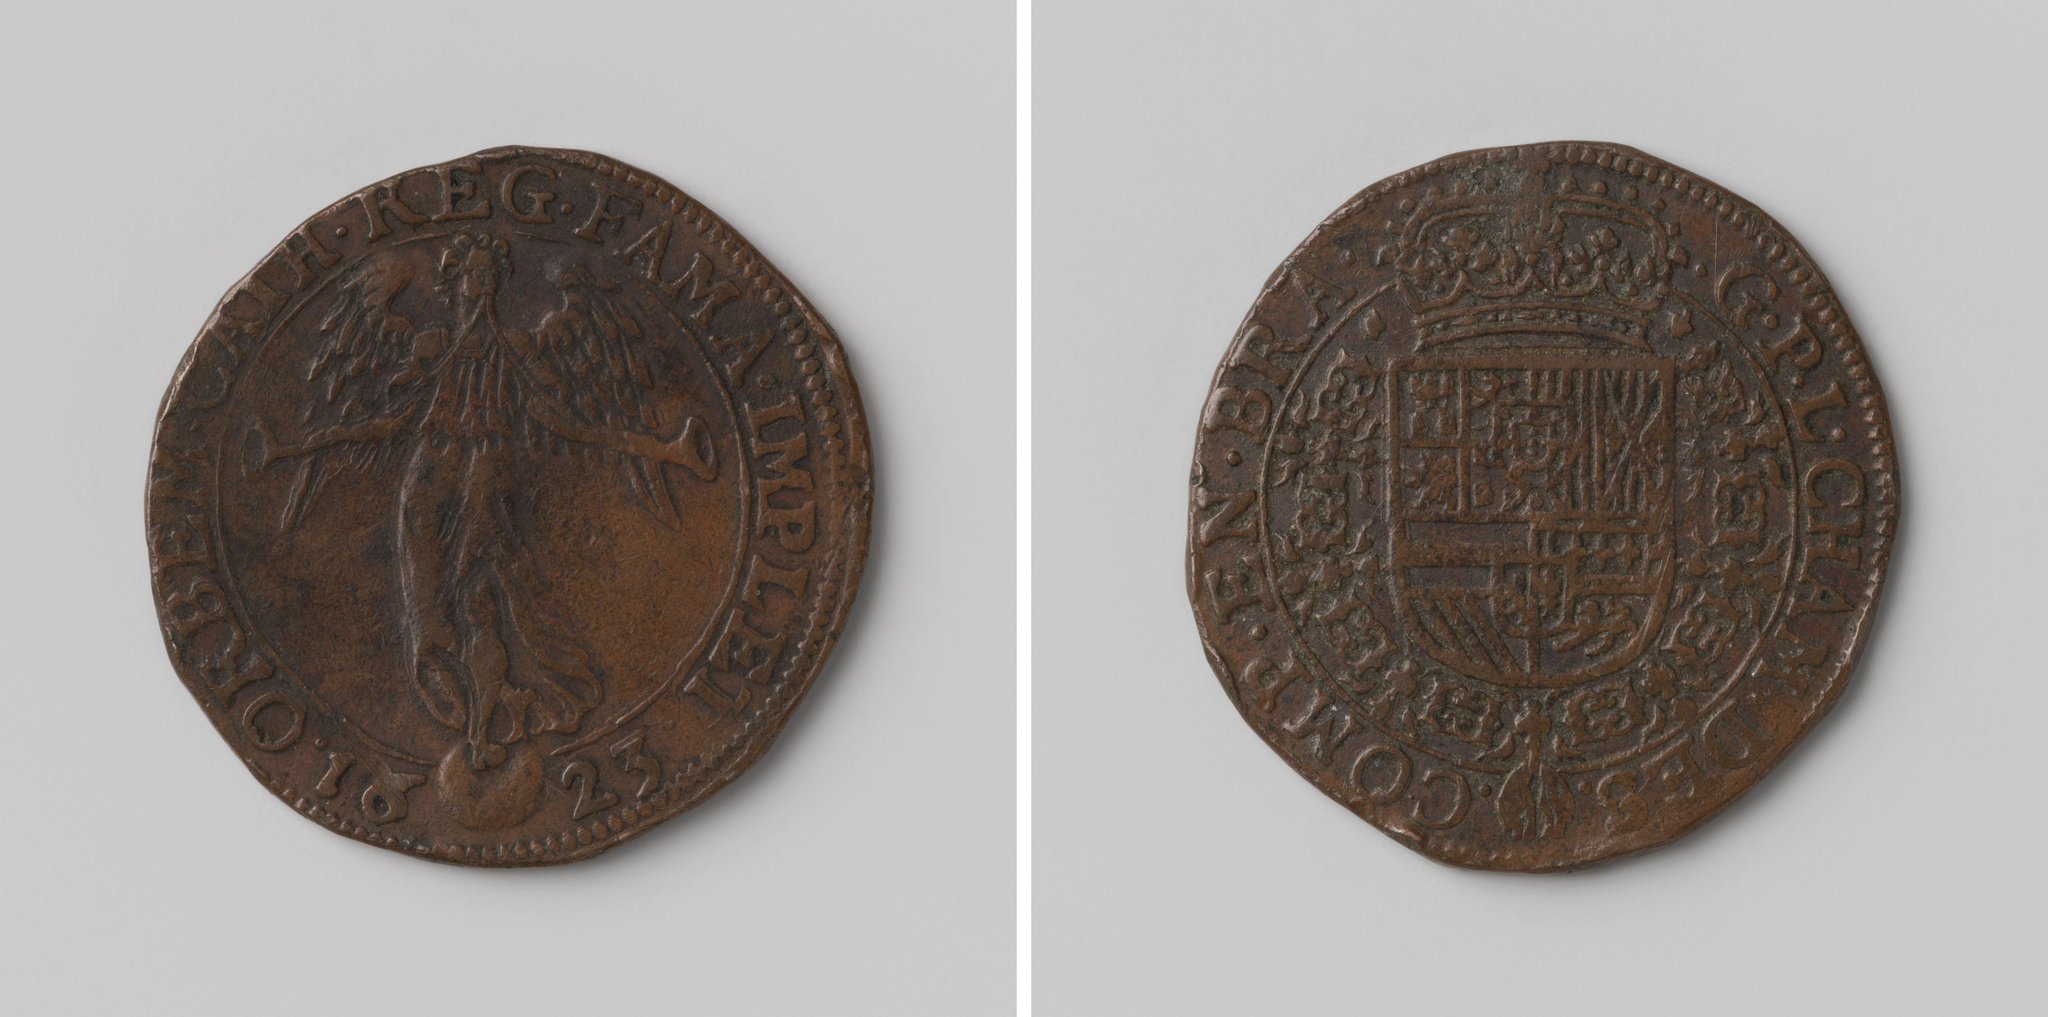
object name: jeton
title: Filips IV, koning van Spanje, rekenpenning geslagen op last van de rekenkamer van Brabant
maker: Anonymous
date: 1623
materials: copper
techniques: striking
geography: belgium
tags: filips iv (koning van spanje), brabant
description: Koperen penning. Voorzijde: Faam, staande op bol, blaast op twee trompetten binnen omschrift. Keerzijde: gekroond wapenschild, omhangen met de orde van het Gulden Vlies binnen omschrift